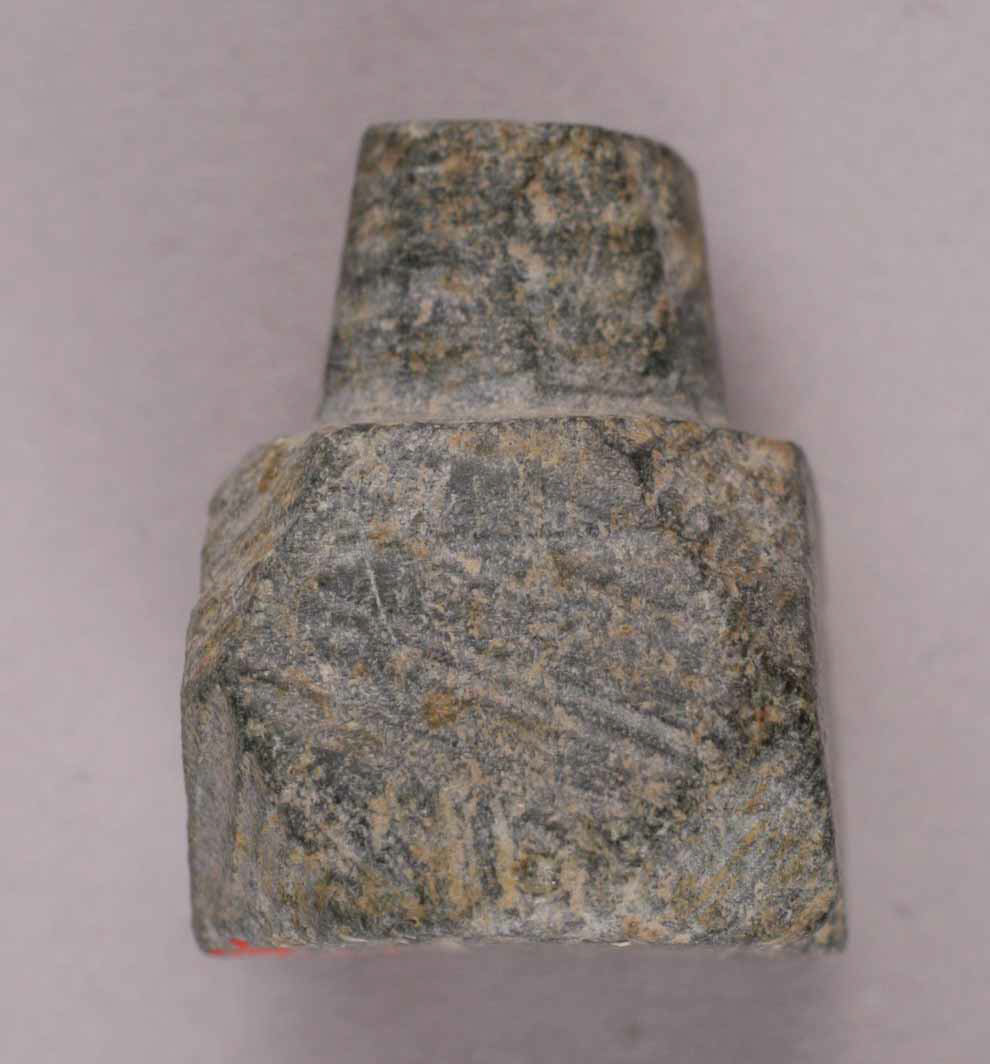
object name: knob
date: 701-1300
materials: stone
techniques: carving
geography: iran